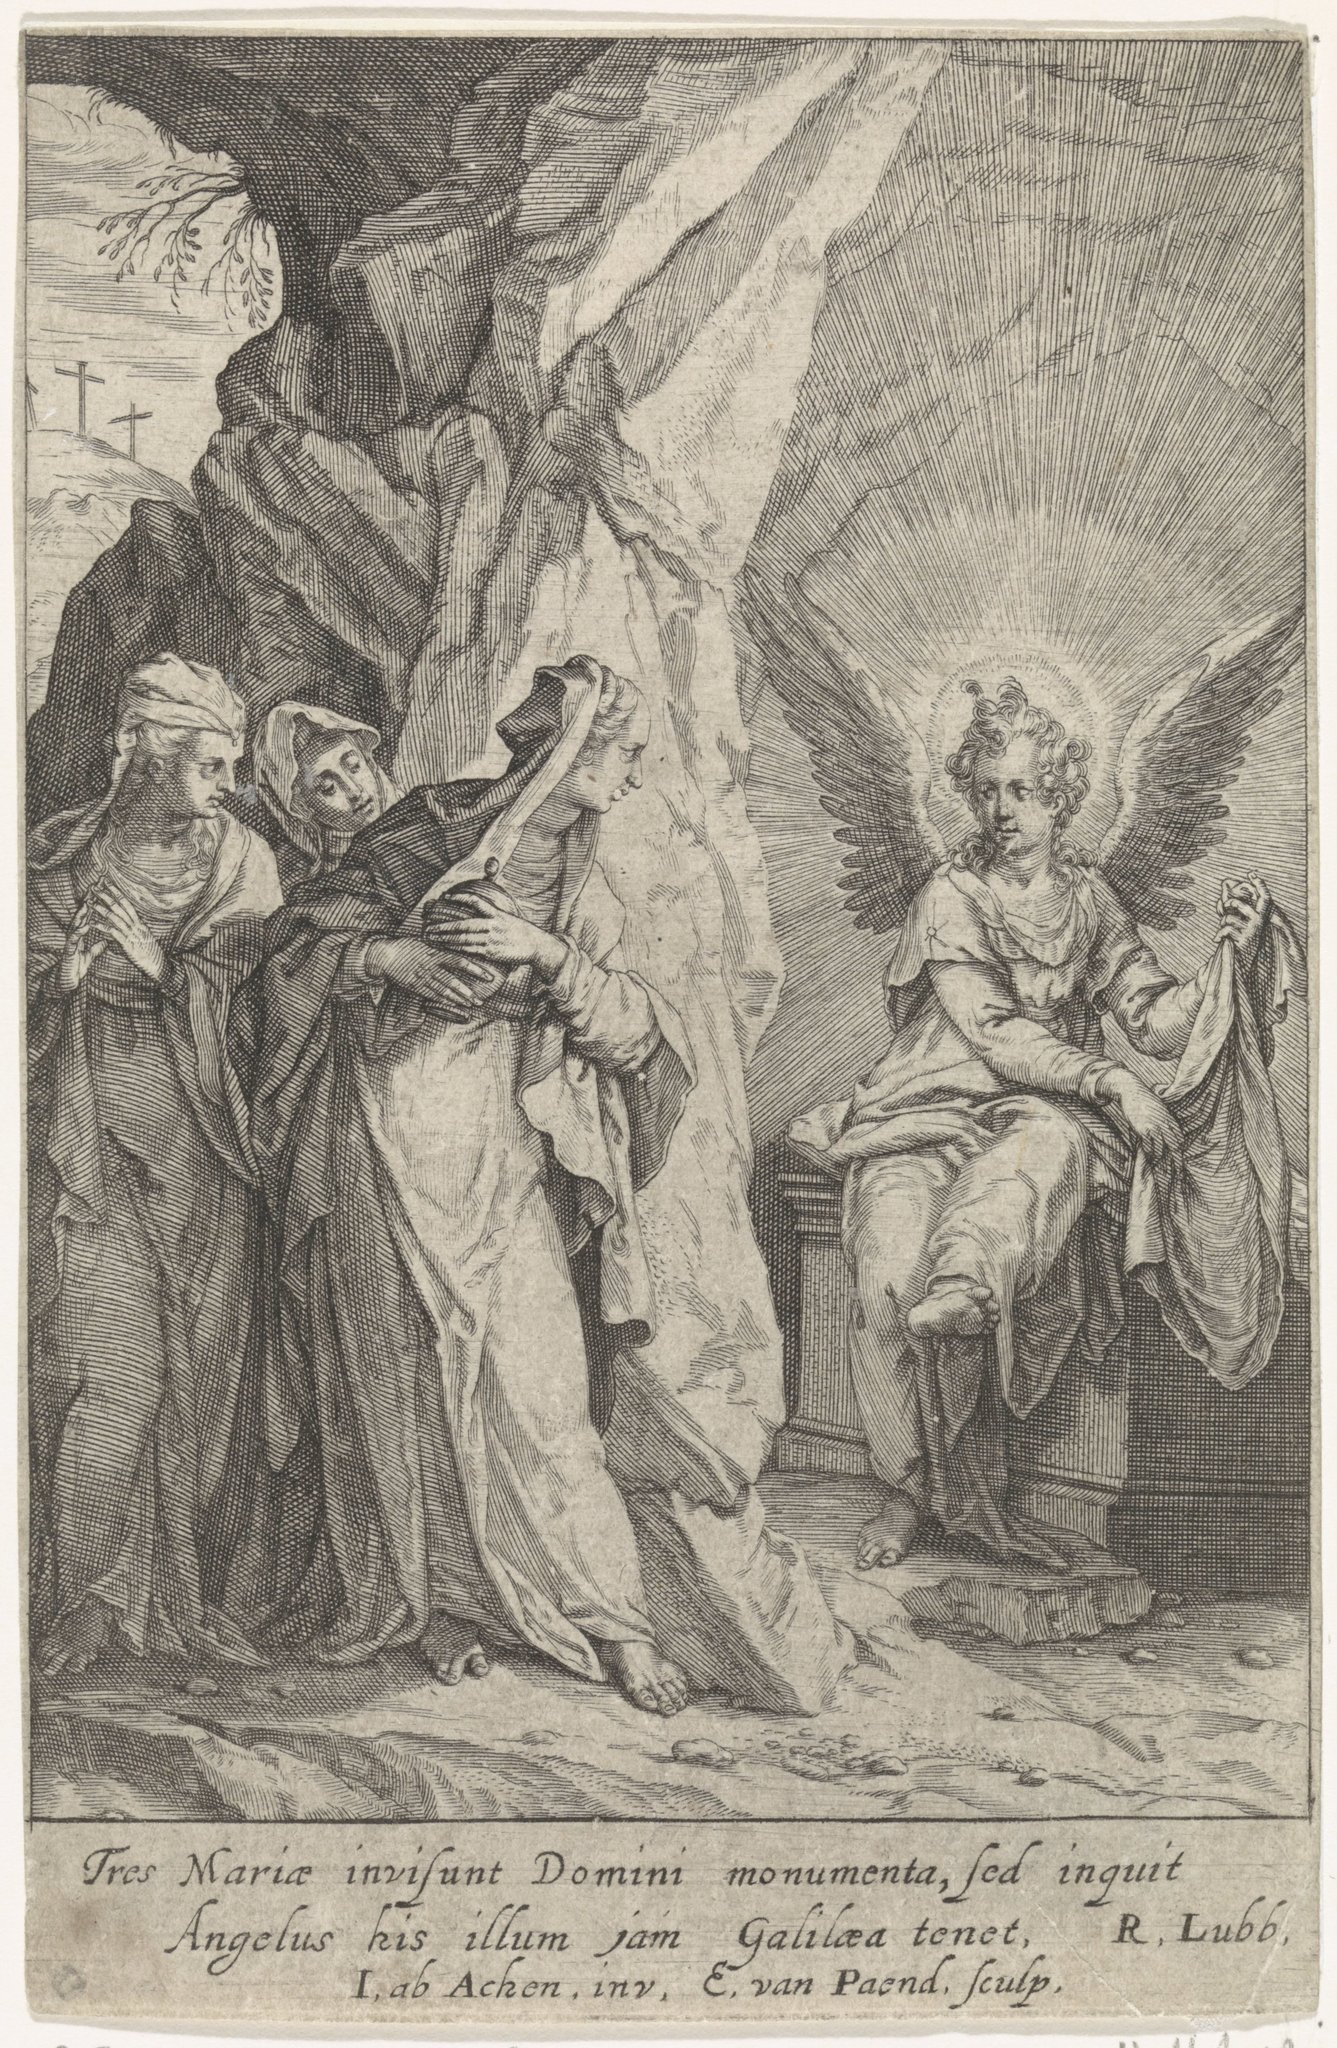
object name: print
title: Drie Maria's bij het graf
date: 1590-1637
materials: paper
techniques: engraving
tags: the holy women (the three maries) on their way to or at the tomb, to anoint christ's body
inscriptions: collector's mark: Lugt 2228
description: Bij het graf van Christus verschijnt een engel aan de drie heilige vrouwen die Christus komen zalven. Eén van hen heeft de zalfpot in haar handen. Op de achtergrond de drie kruizen. In de marge een tweeregelig onderschrift in het Latijn.